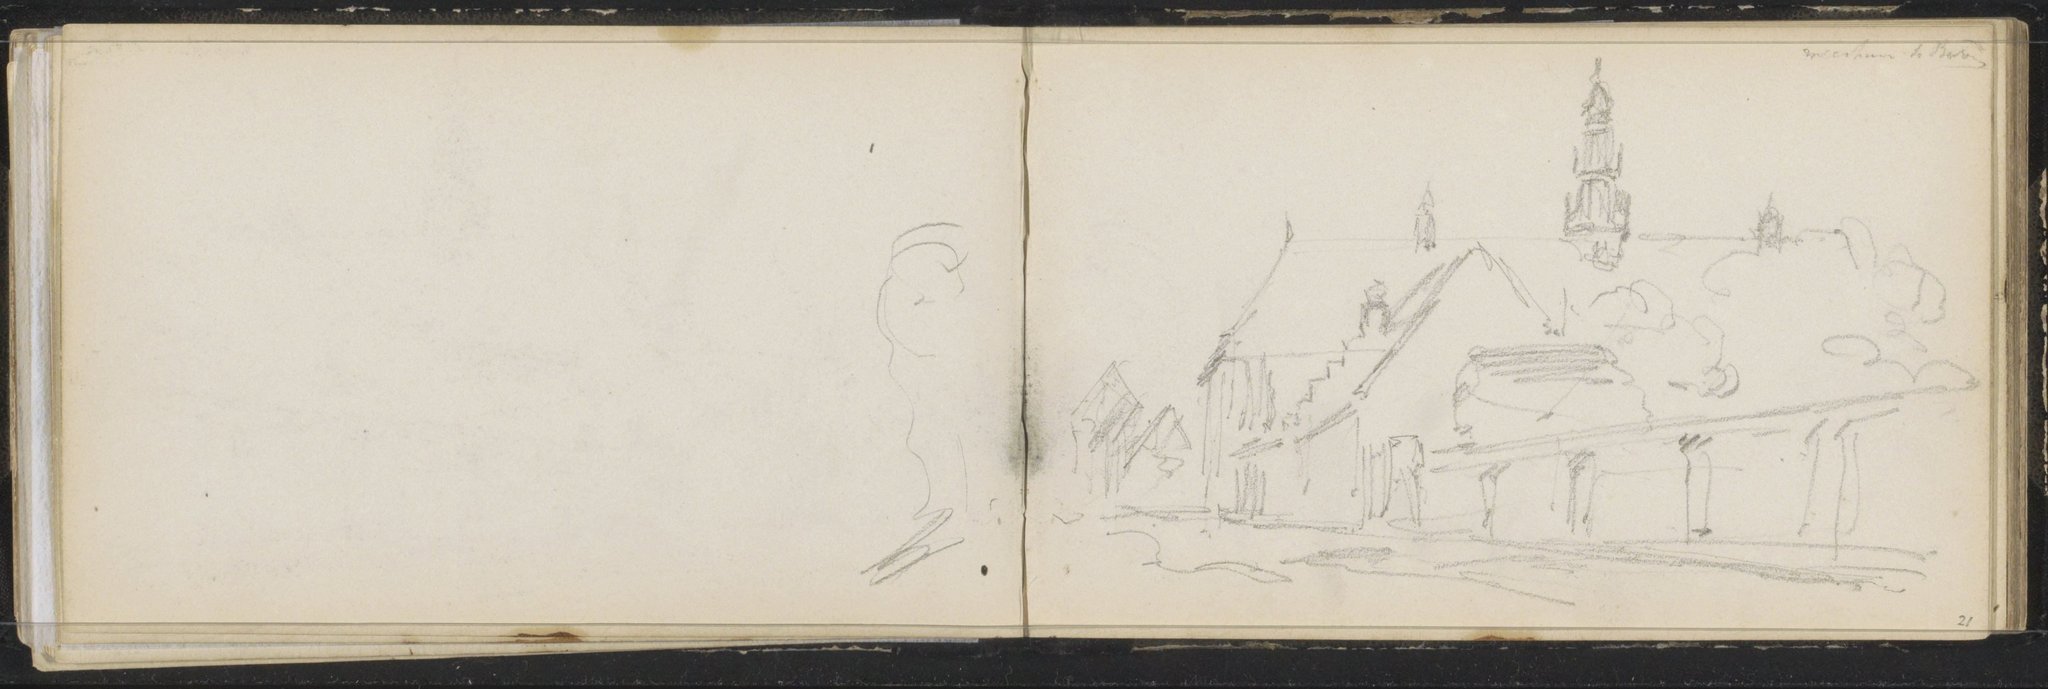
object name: sketchbook leaf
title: Gezicht op het Koninklijk Weeshuis te Buren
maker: cornelis springer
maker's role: draughtsman, painter, print maker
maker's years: 1817-1891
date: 1863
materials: paper, pencil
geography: buren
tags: orphanage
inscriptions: annotation: ‘weestuin te Buren’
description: Gezicht op het Koninklijk Weeshuis te Buren en zijn ommuurde tuin. Blad 20 verso en blad 21 recto uit een schetsboek met 55 bladen vervaardigd op de Veluwe en in Noord-Duitsland.